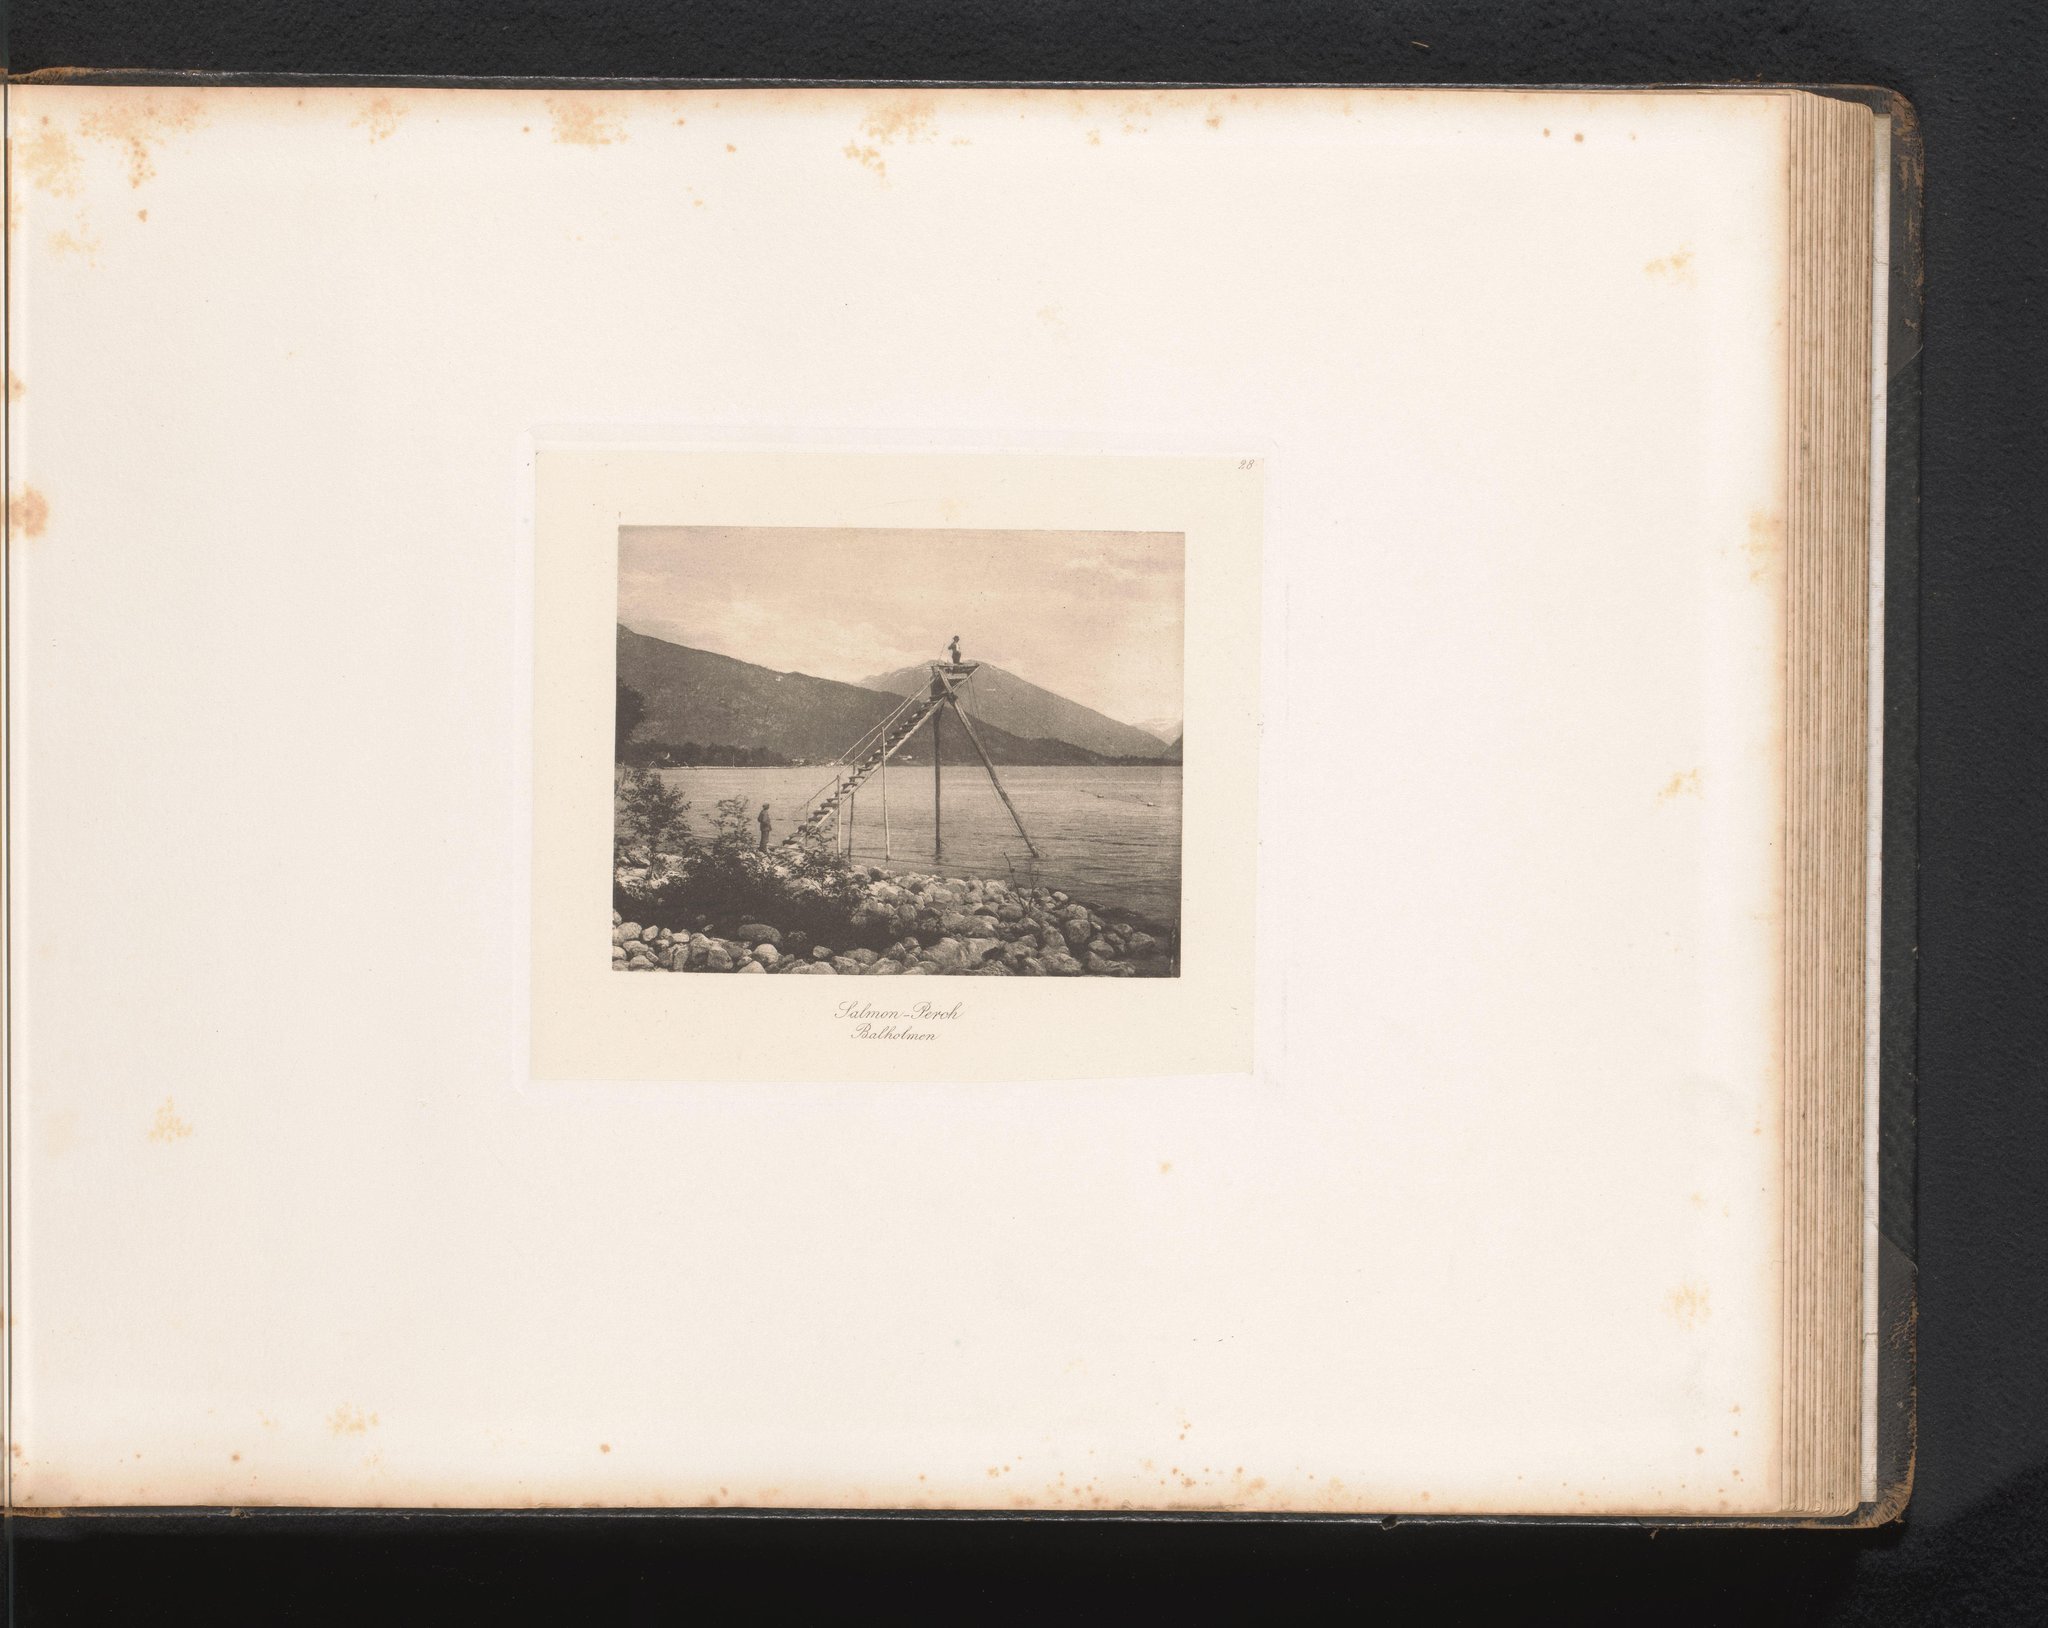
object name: page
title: Gezicht op het Sognefjord met visplatform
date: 1888-1893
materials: paper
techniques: photograph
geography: vienna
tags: fjord, sea loch, mountains (+ landscape with figures, staffage), fisherman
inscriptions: number: ‘28’